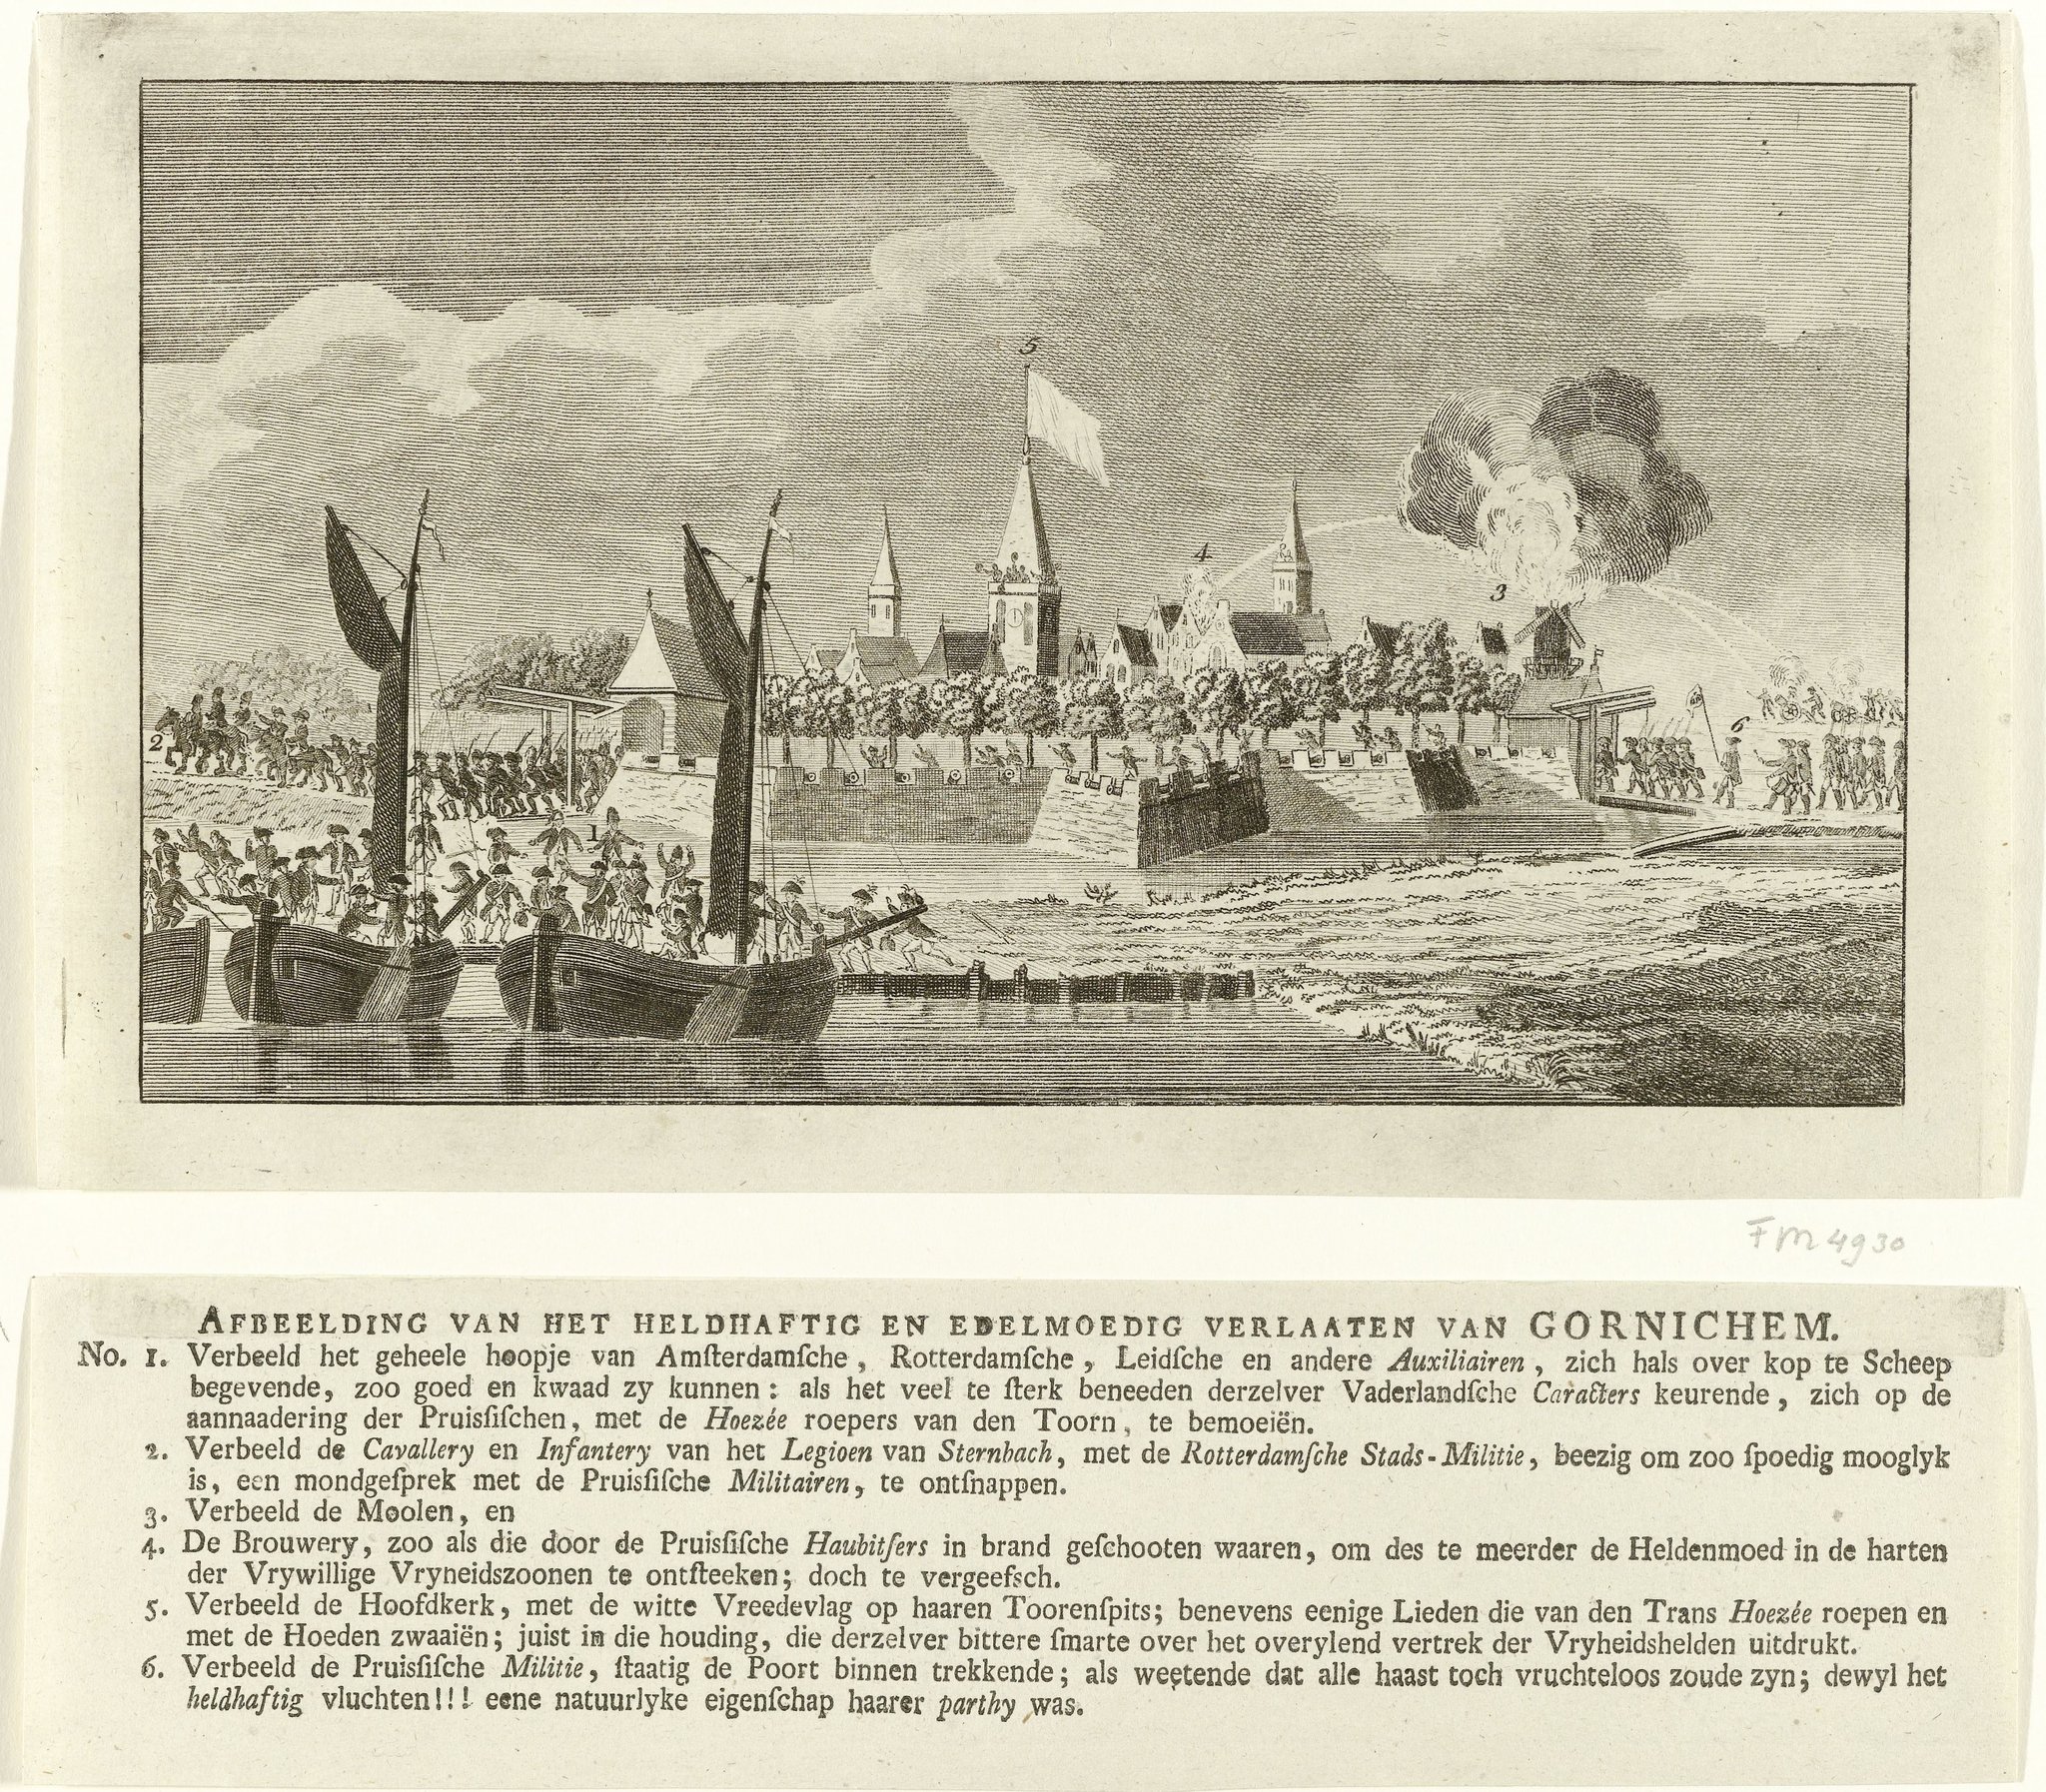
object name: print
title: Patriotten verlaten Gorinchem, 1787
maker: Anonymous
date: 1787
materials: paper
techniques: engraving, etching, letterpress printing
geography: northern netherlands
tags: putting the enemy to flight - hh - being put to flight, fleeing (+ citizen soldiery, civil guard, citizen militia)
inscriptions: collector's mark: Lugt 2228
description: Sporprent op de patriotten die de stad Gorinchem ontvluchten bij de komst van de Pruisische troepen, 17 september 1787. Rechts beschieten de Pruisen de stad, links vluchten de patriotten uit de stad naar gereedstaande boten. Op de kerktoren wappert de witte vlag. Papier met afdruk van de onderzijde van de plaat en de satirische tekst met legenda 1-6 afgesneden en los bijgevoegd.